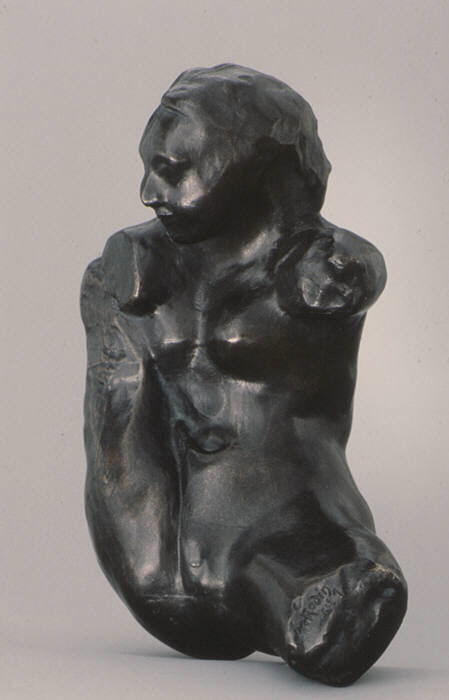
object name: statuette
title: Small Torso of Iris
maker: auguste rodin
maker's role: artist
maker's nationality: french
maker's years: 1840-1917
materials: bronze, marble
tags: goddess